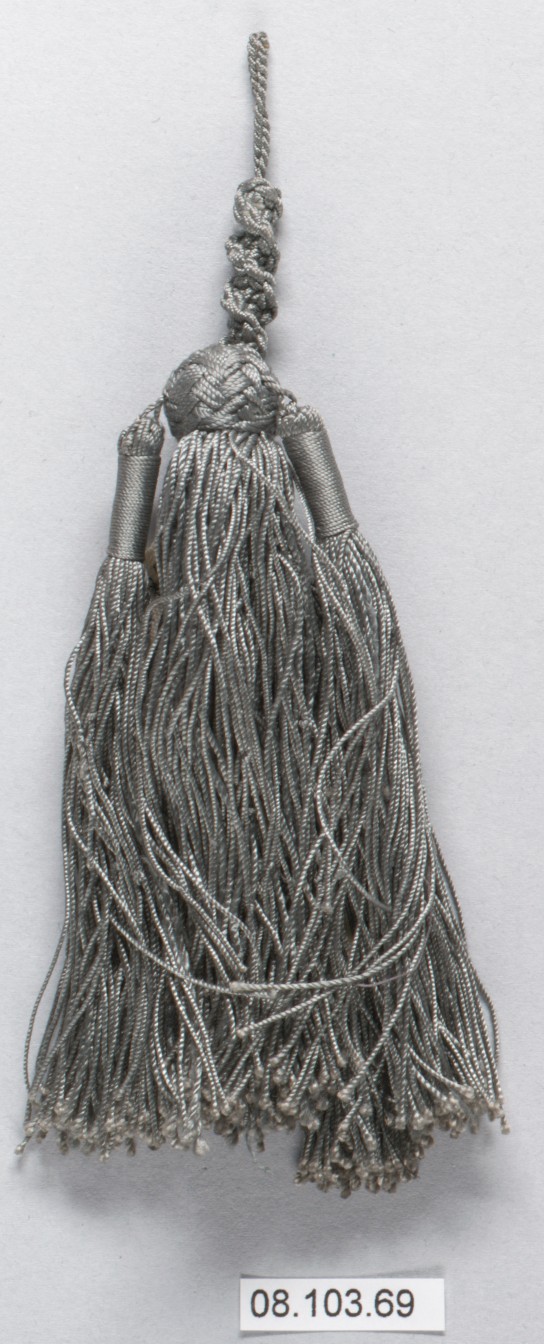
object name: tassel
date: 1801-1900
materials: silk